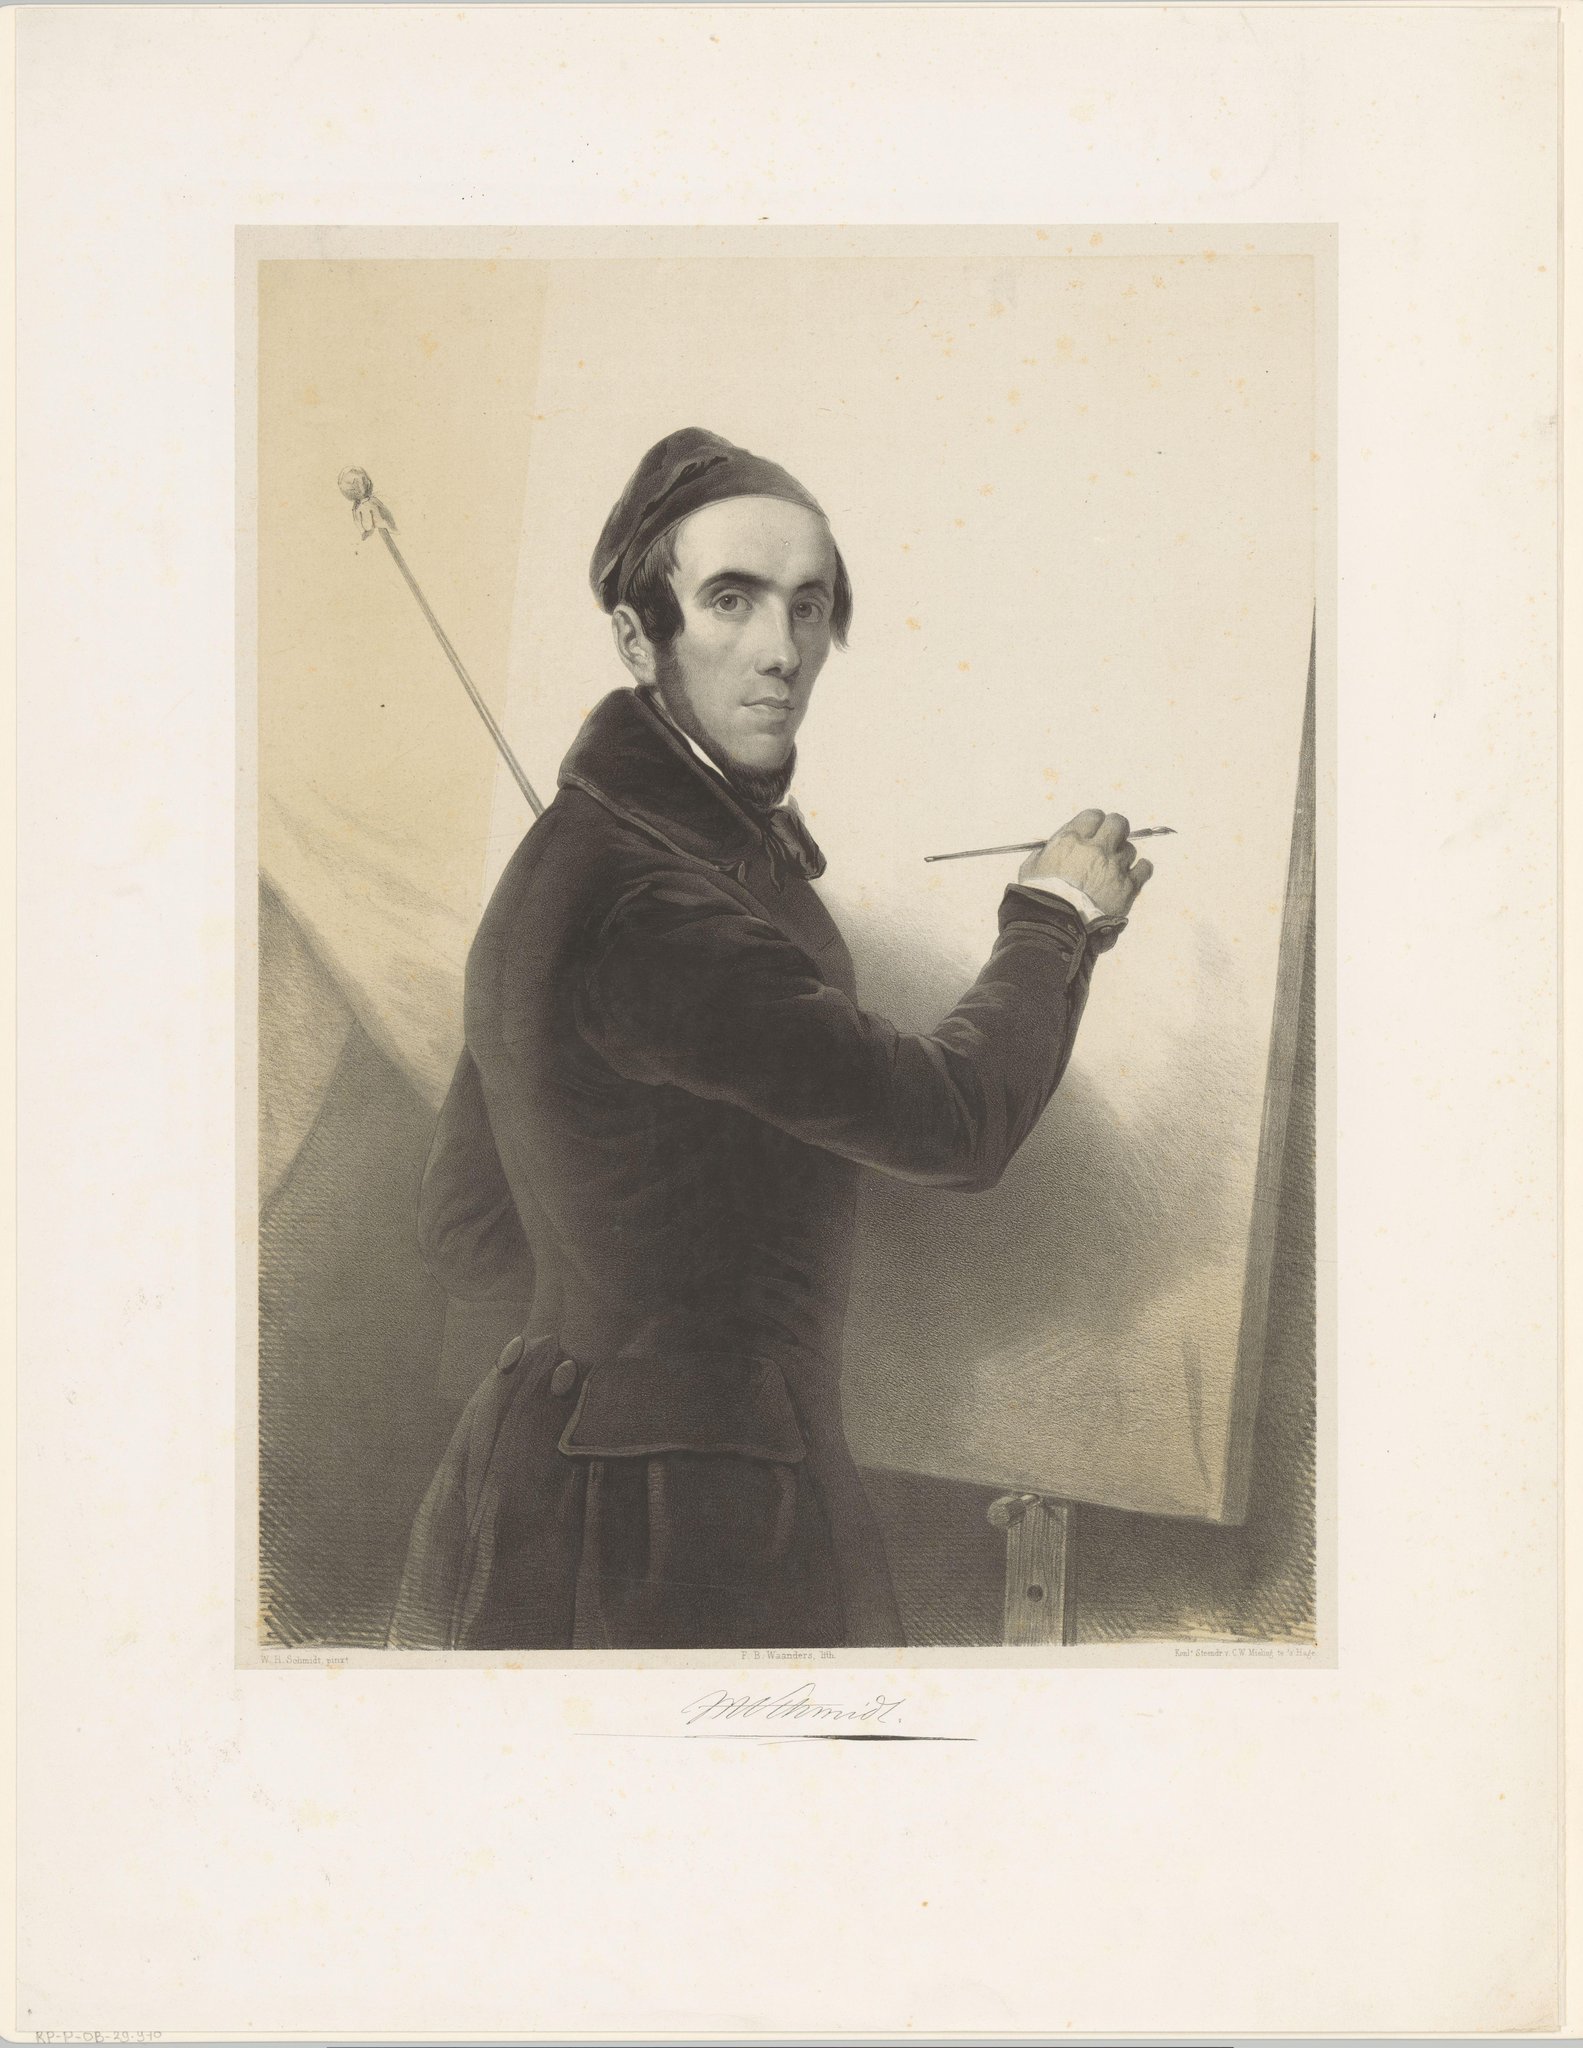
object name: print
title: Zelfportret van Willem Hendrik Schmidt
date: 1847-1849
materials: paper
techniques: tone lithography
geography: the hague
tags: rotterdam, delft, painter, print maker, draughtsman, willem hendrik schmidt, historical persons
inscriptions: collector's mark: Lugt 2228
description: De geportretteerde staat voor zijn schildersezel. Onder het portret de signatuur van de geportretteerde.